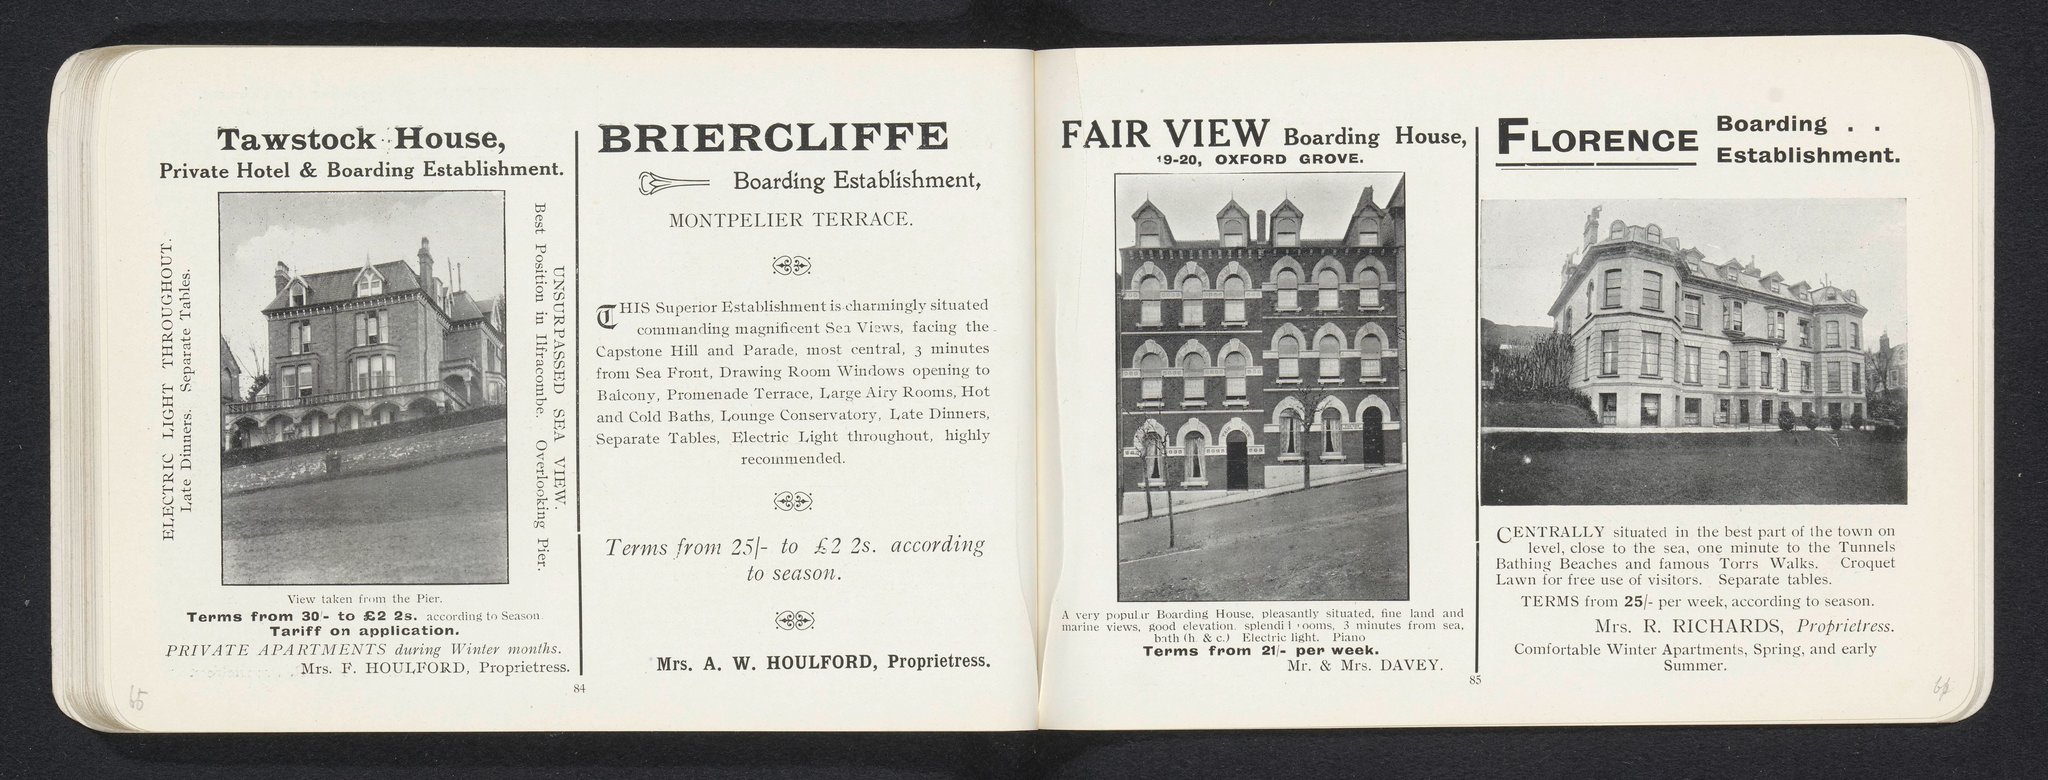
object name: photomechanical print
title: Voorgevel van Tawstock House te Ilfracombe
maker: Anonymous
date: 1900-1920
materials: paper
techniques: autotype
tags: façade (of house or building), hotel, hostelry, inn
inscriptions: inscription: ‘Tawstock House (...) W. Houlford, Proprietress.’